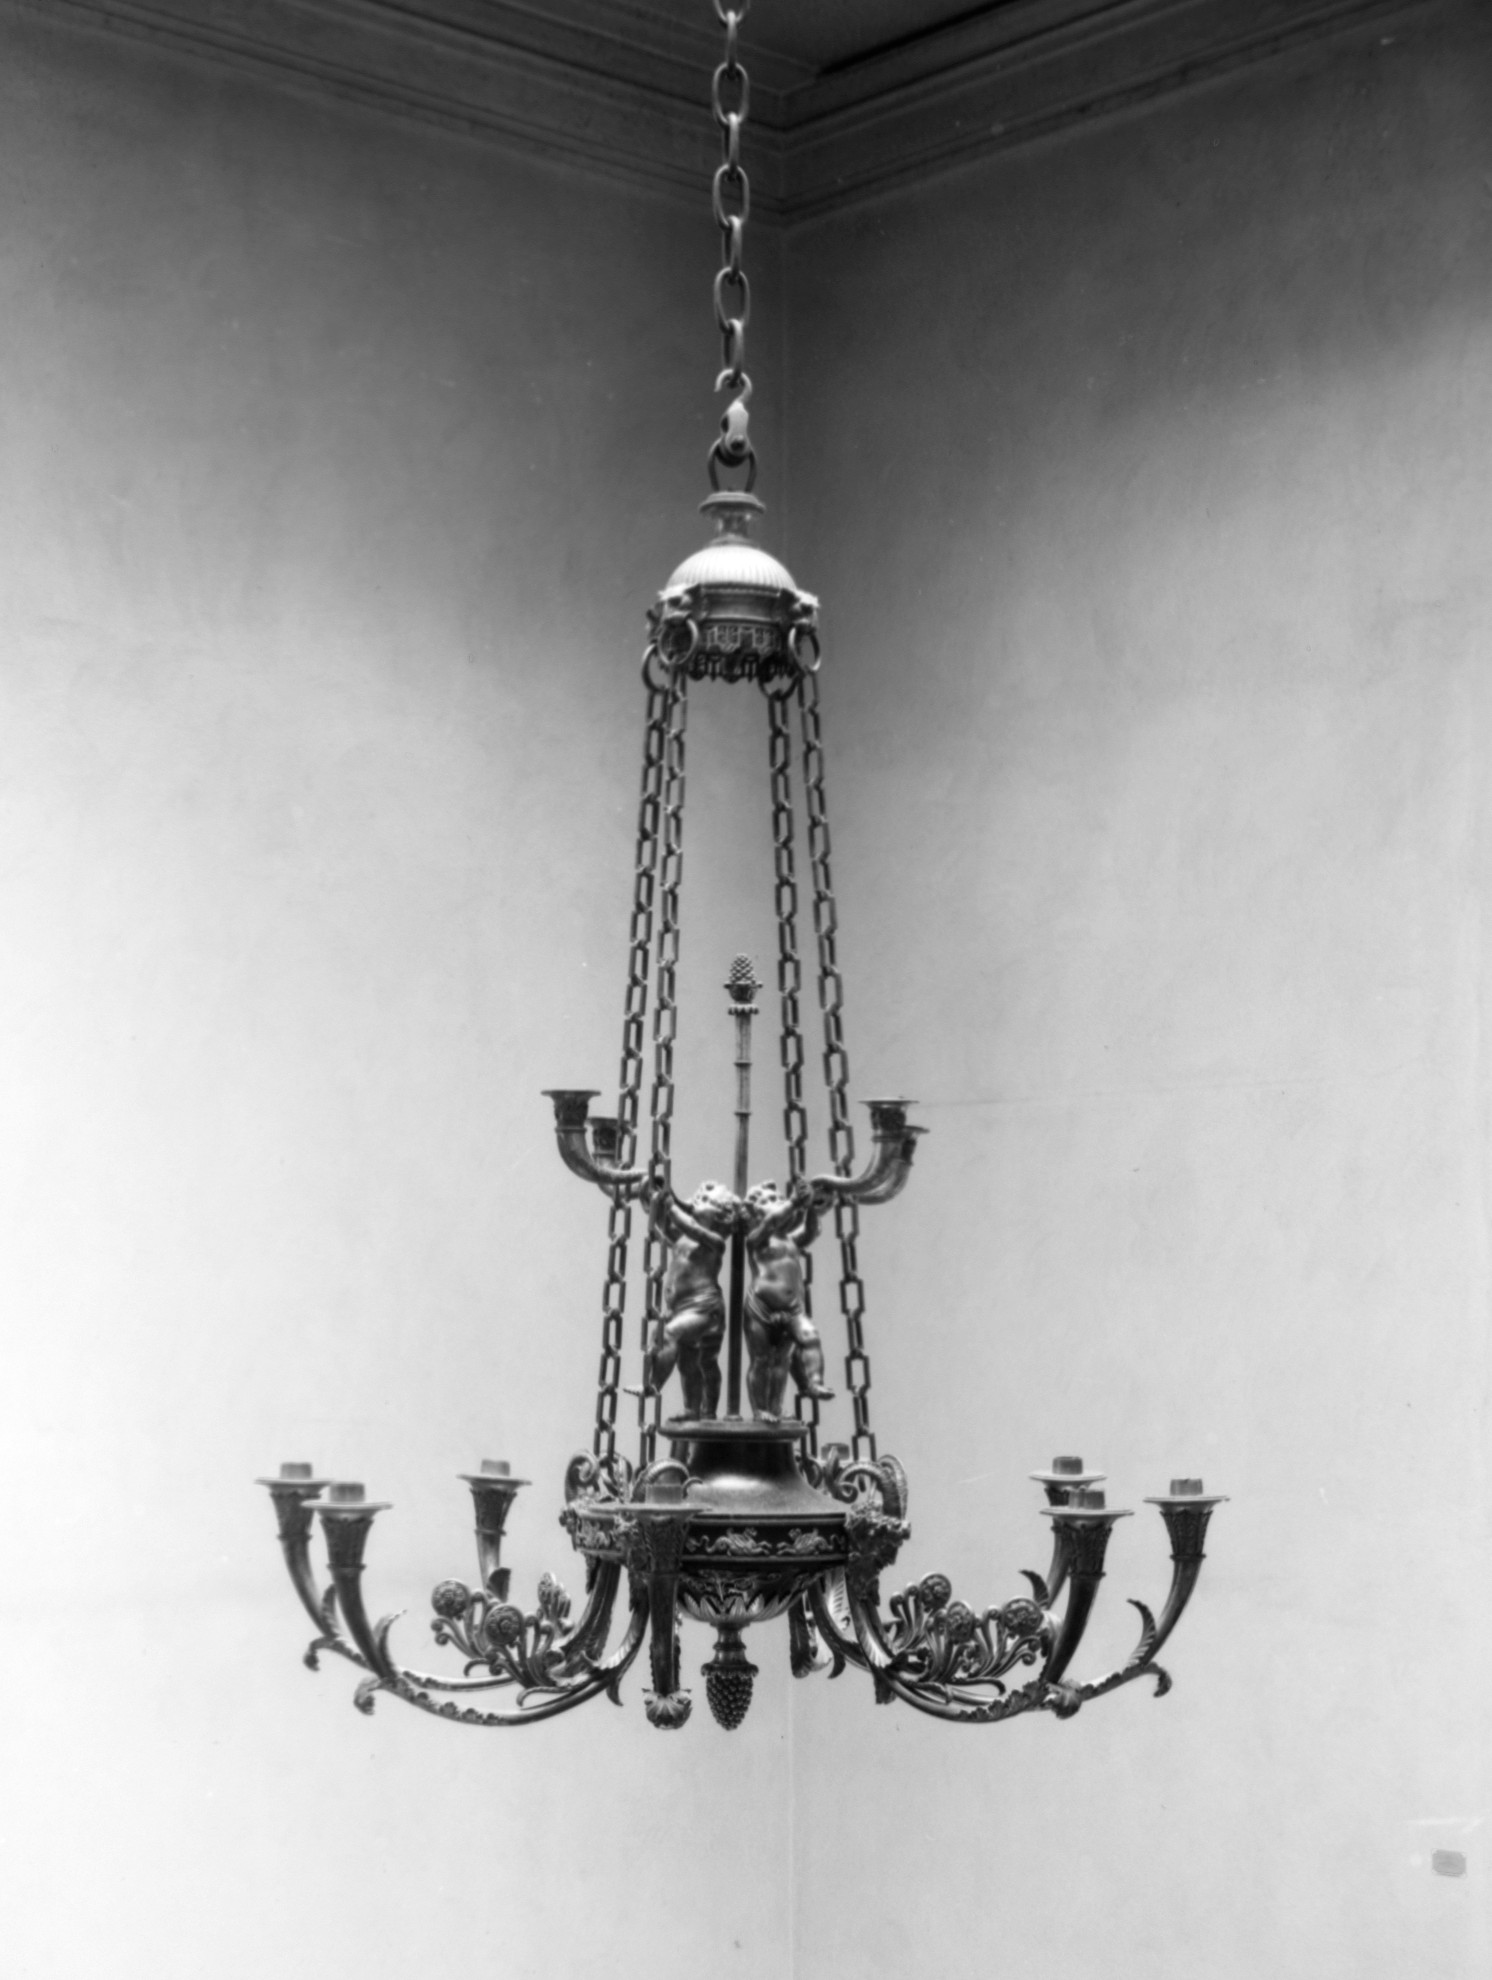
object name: chandelier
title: Twelve-light chandelier (Lustre)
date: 1790-1800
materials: bronze, gilt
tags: putti